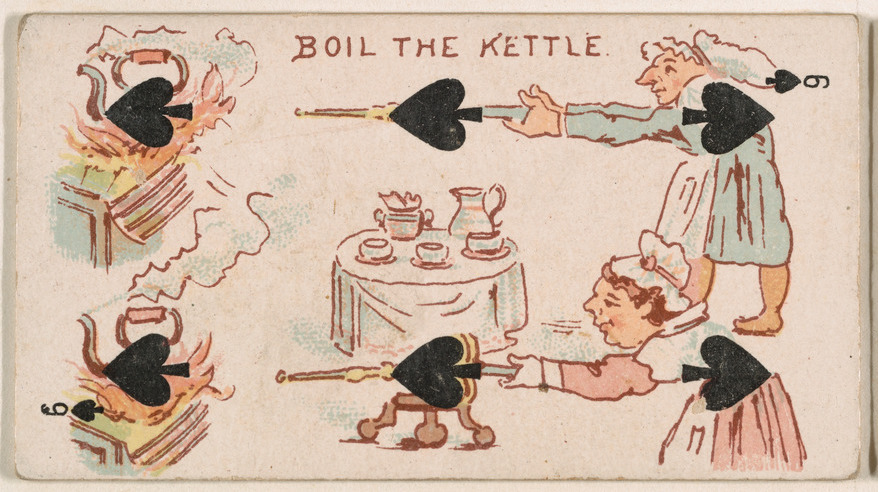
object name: print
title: Six of Spades, Boil the Kettle, from Harlequin Cards, 2nd Series (N220) issued by Kinney Bros.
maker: kinney brothers tobacco company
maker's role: publisher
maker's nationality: american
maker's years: 1869-2011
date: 1889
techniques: color lithograph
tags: women,playing cards